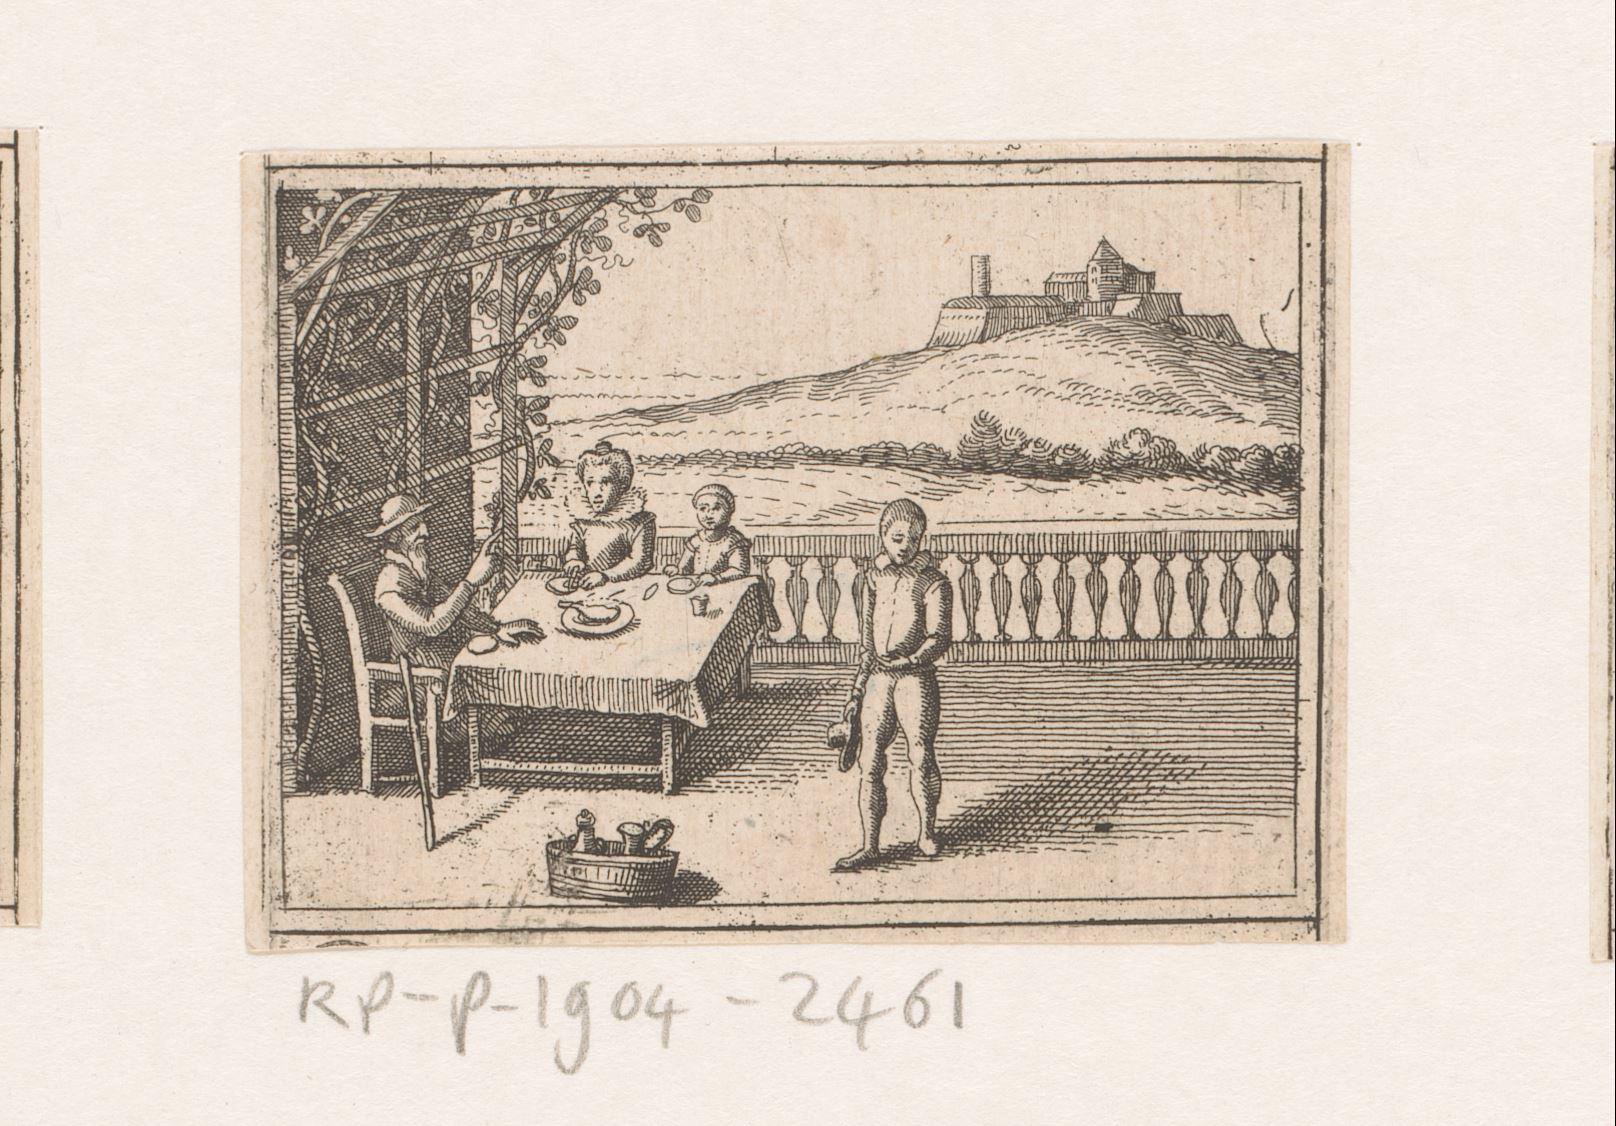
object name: book illustration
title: Gezin aan tafel met kasteel in de achtergrond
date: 1624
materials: paper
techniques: etching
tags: castle, (family) meal - cc - out of doors (+ shape of laid table)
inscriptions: collector's mark: Lugt 2228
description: Prent uit: Sudermann, Daniel. Centuria Similitudinum, Hubert Gleichnussen. Straatsburg, Jacob van der Heyden, 1624. (Hollstein German XXVIA 646).